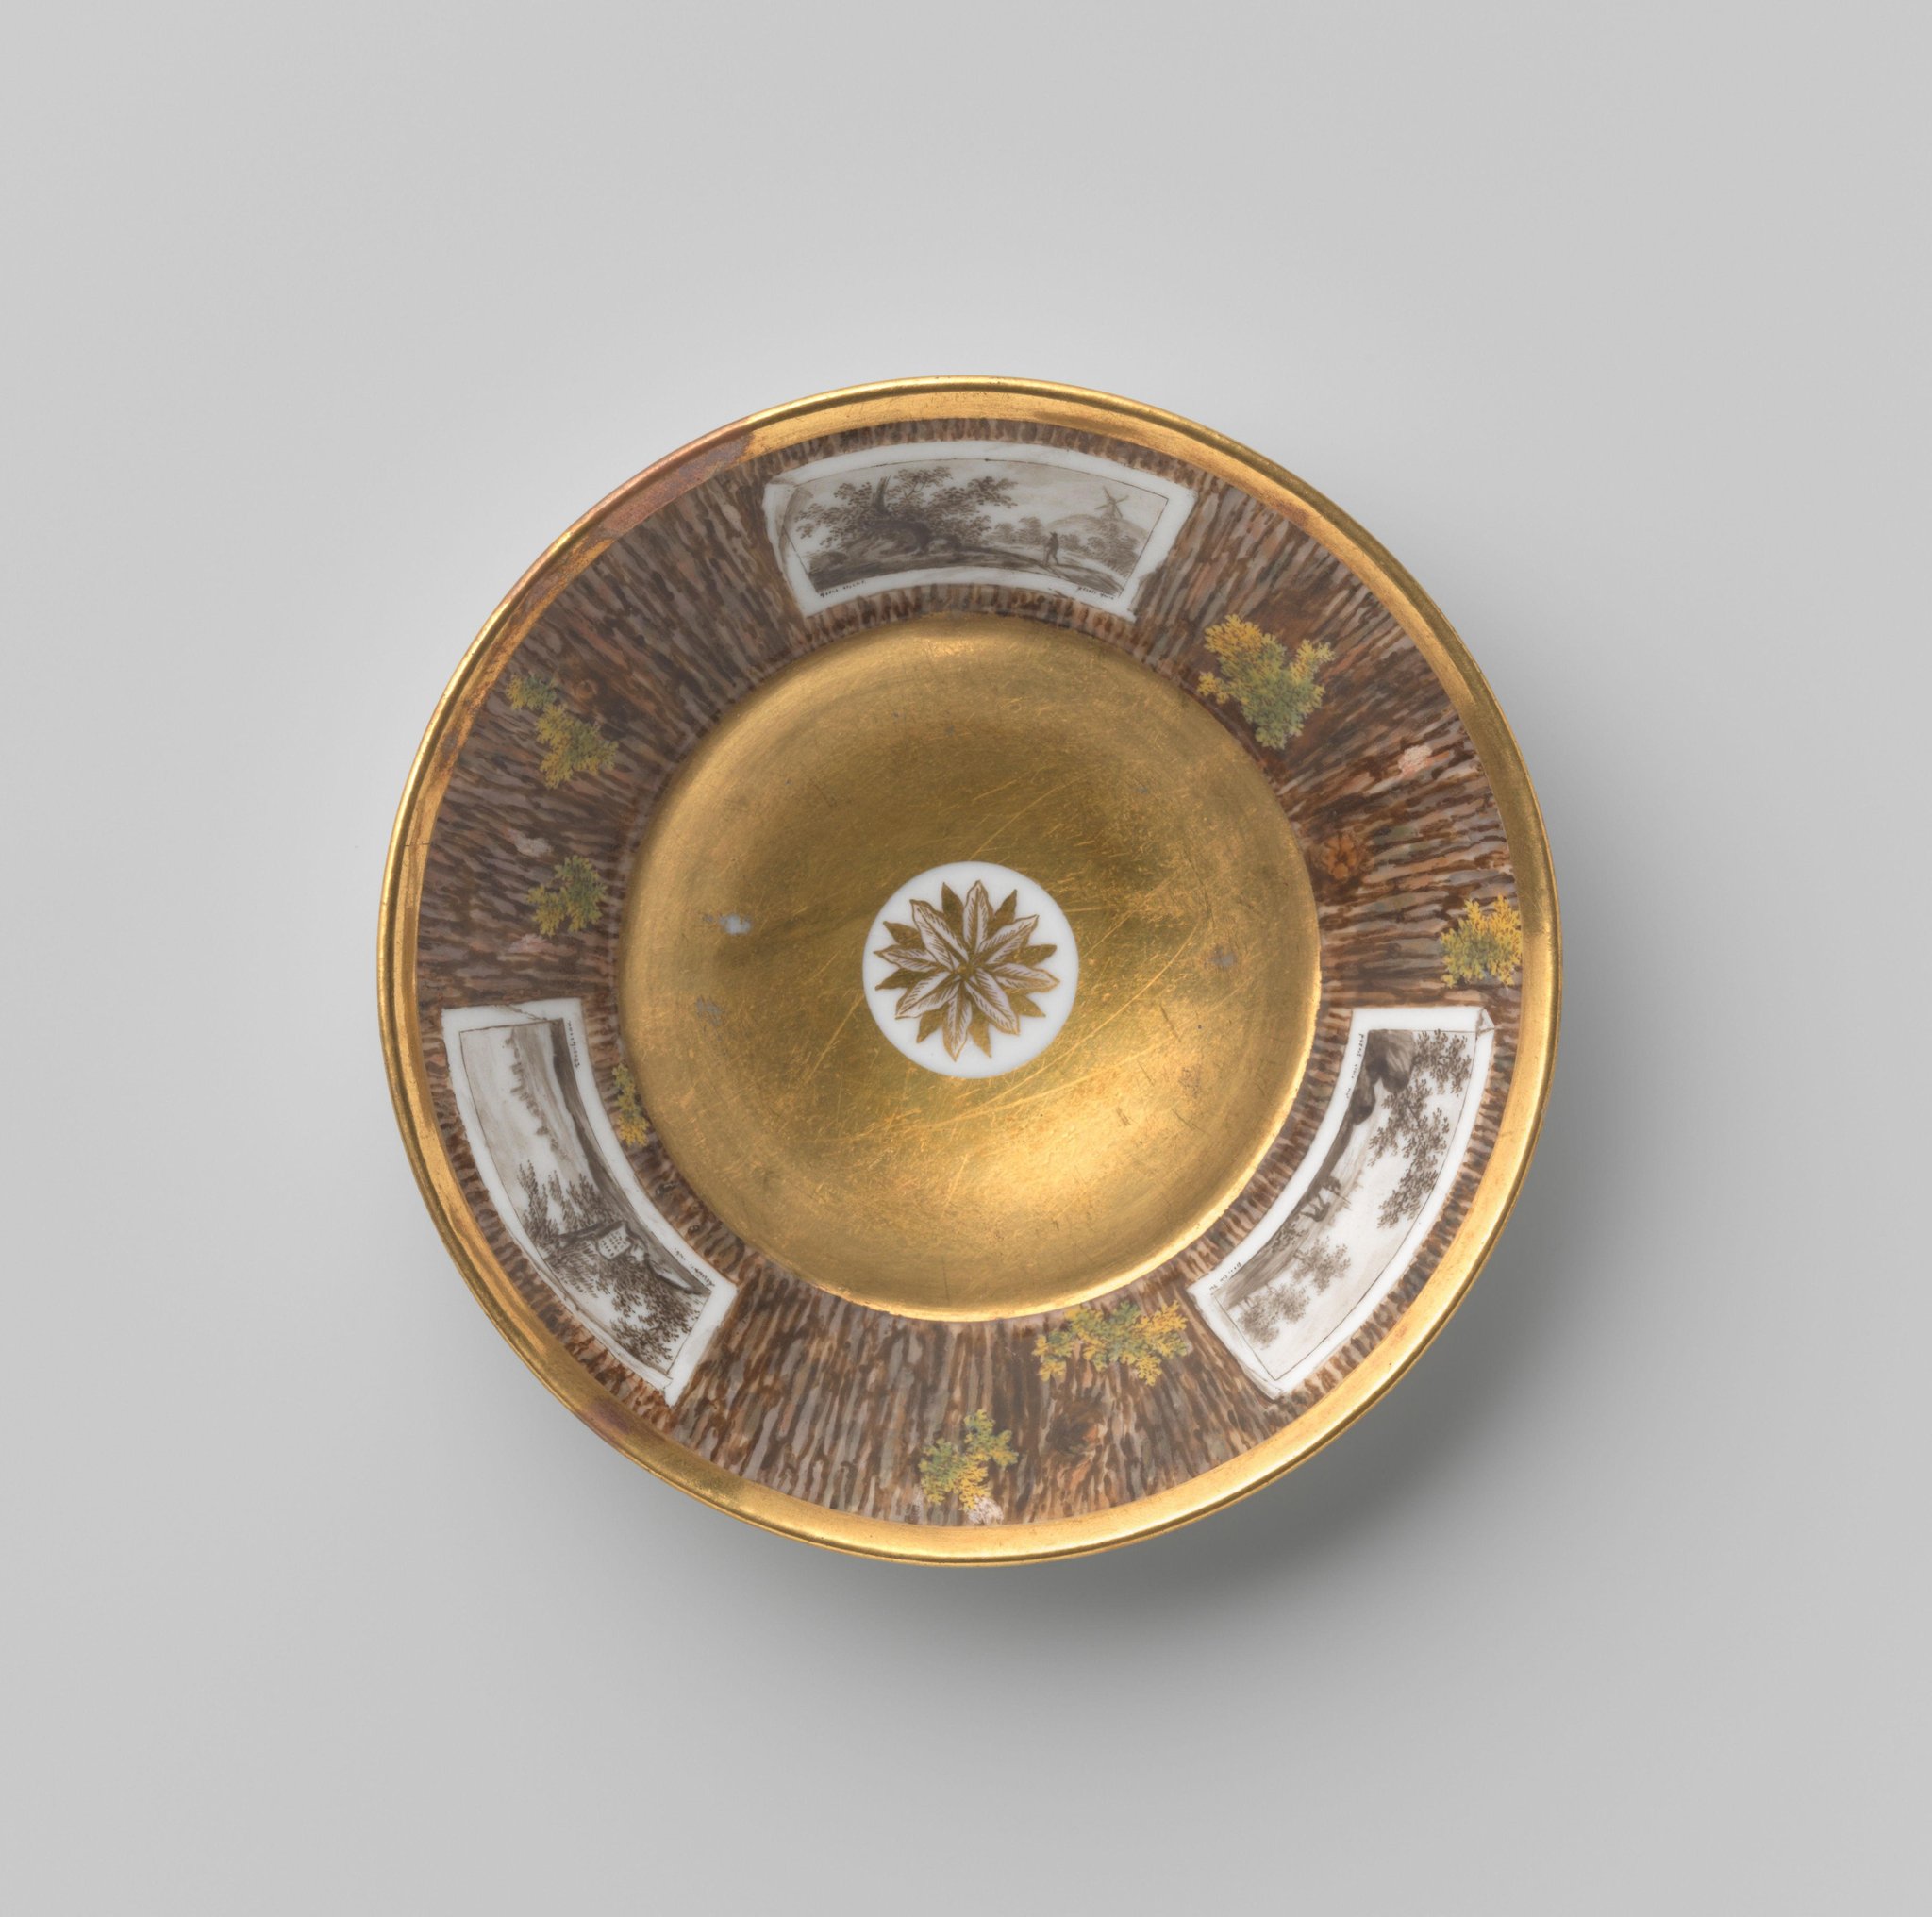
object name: platter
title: Saucer with landscapes on a ground of imitation bark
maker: Anonymous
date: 1775-1799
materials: glaze, gold, paint, porcelain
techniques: firing, forming, gilding, turning, vitrification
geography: paris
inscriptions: mark: ‘B’, mark: ‘REVIL, Rue/ Neuve des/ Capucines’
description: Schotel van porselein met een rechte wand, beschilderd op het glazuur in emailkleuren en goud. Op het plat een rozet uitgespaard in goud. De binnenwand is bedekt met imitatieboomschors met mos, waar drie affiches met een landschap op lijken geplakt. Gouden rand en lijn boven de voet. Gemerkt op de onderzijde met 'REVIL, Rue/ Neuve des/ Capucines' en een B.